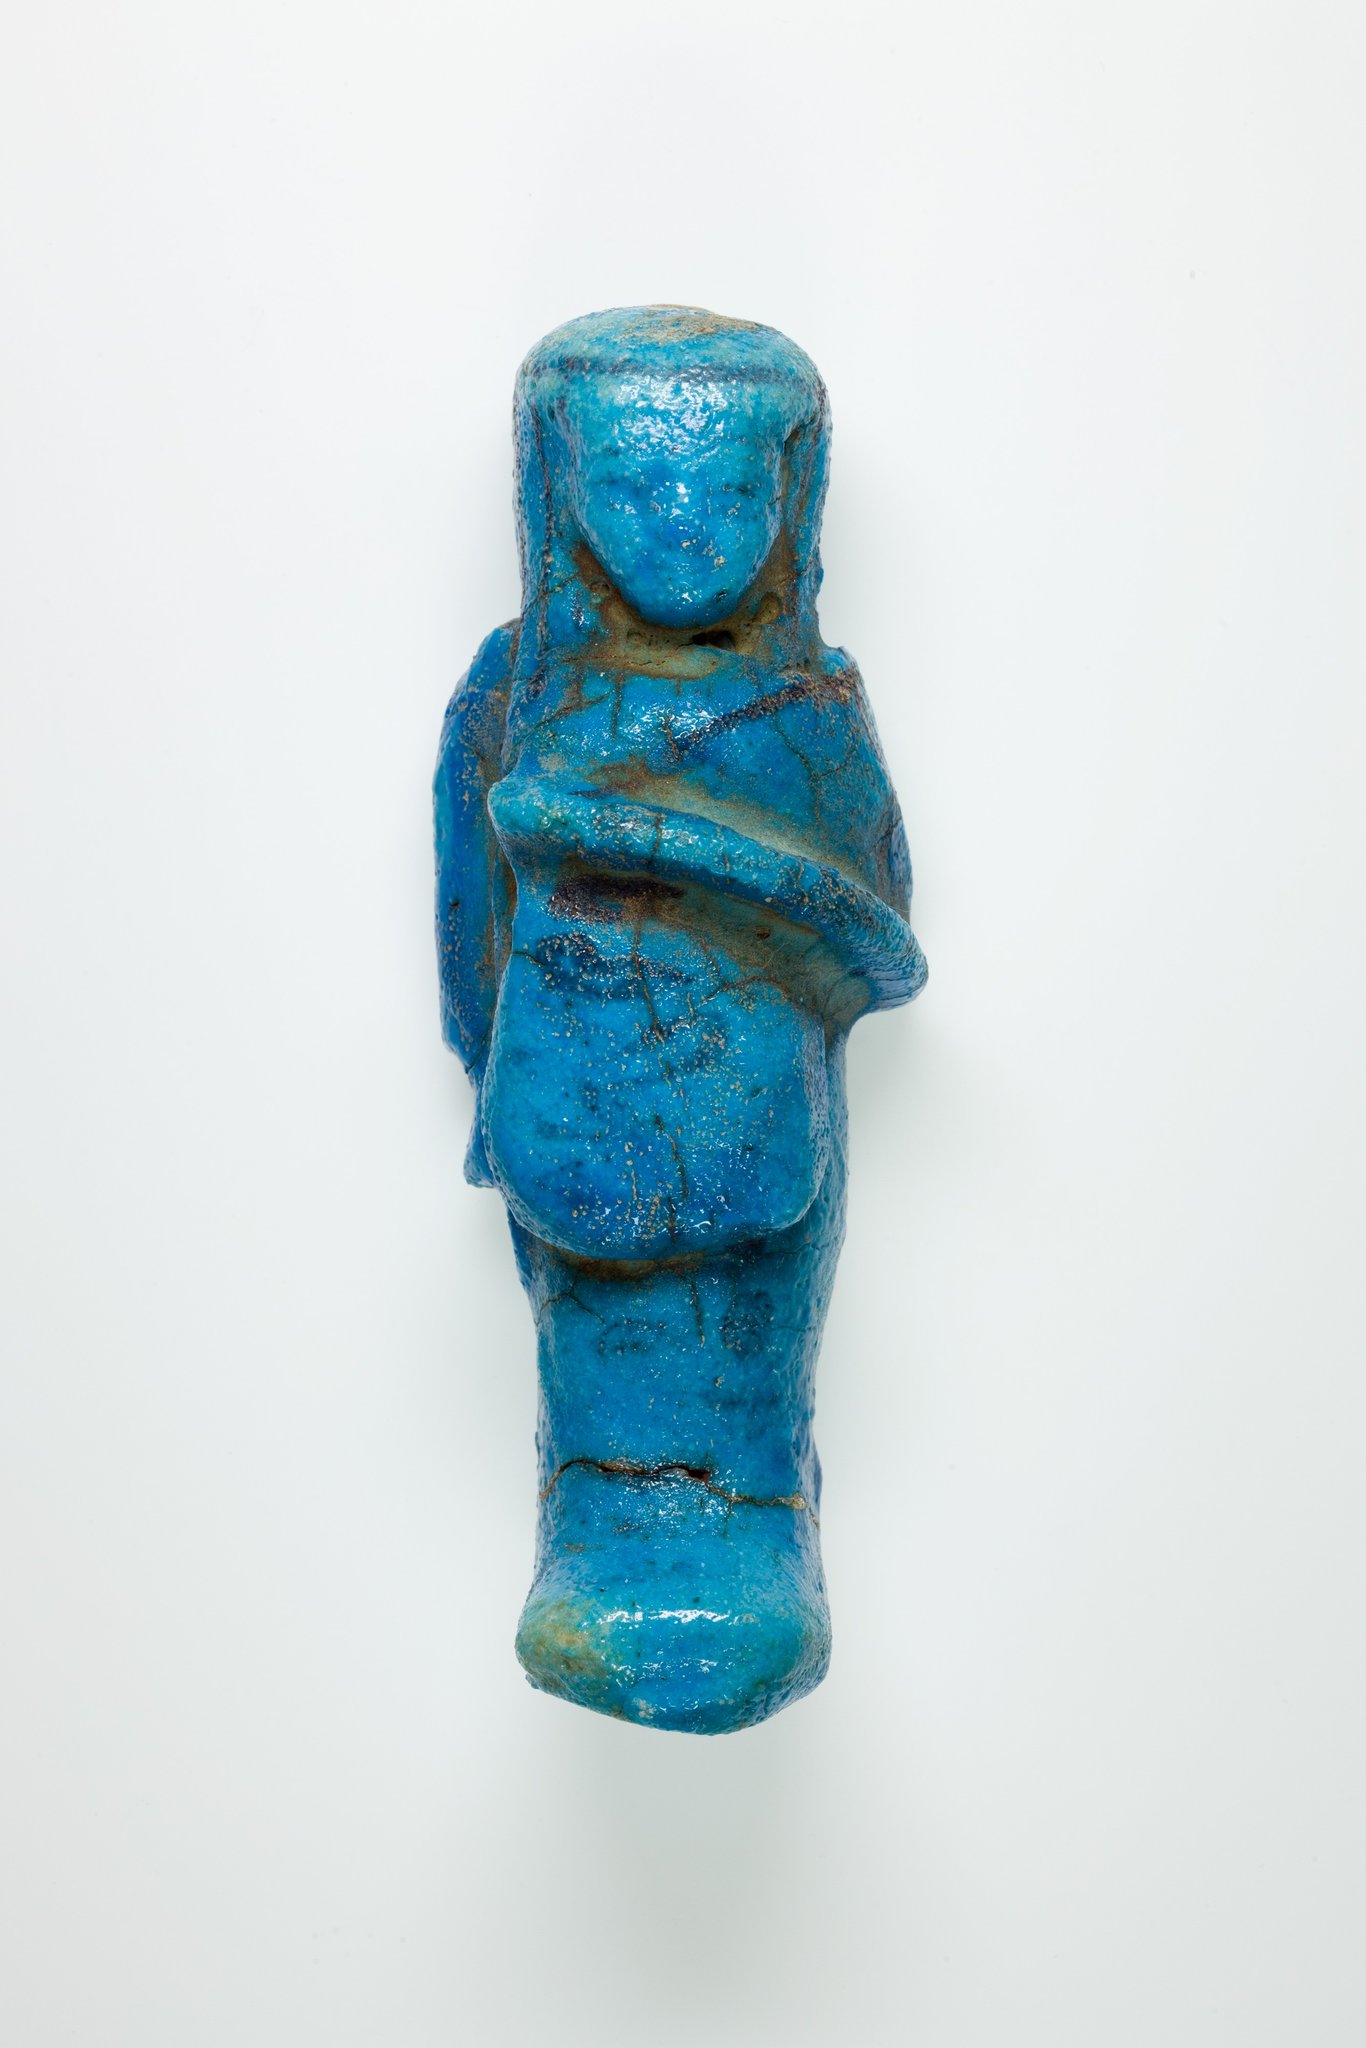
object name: overseer shabti, henettawy c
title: Overseer Shabti of Henettawy (C), Daughter of Isetemkheb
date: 990-970 BCE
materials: faience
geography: egypt